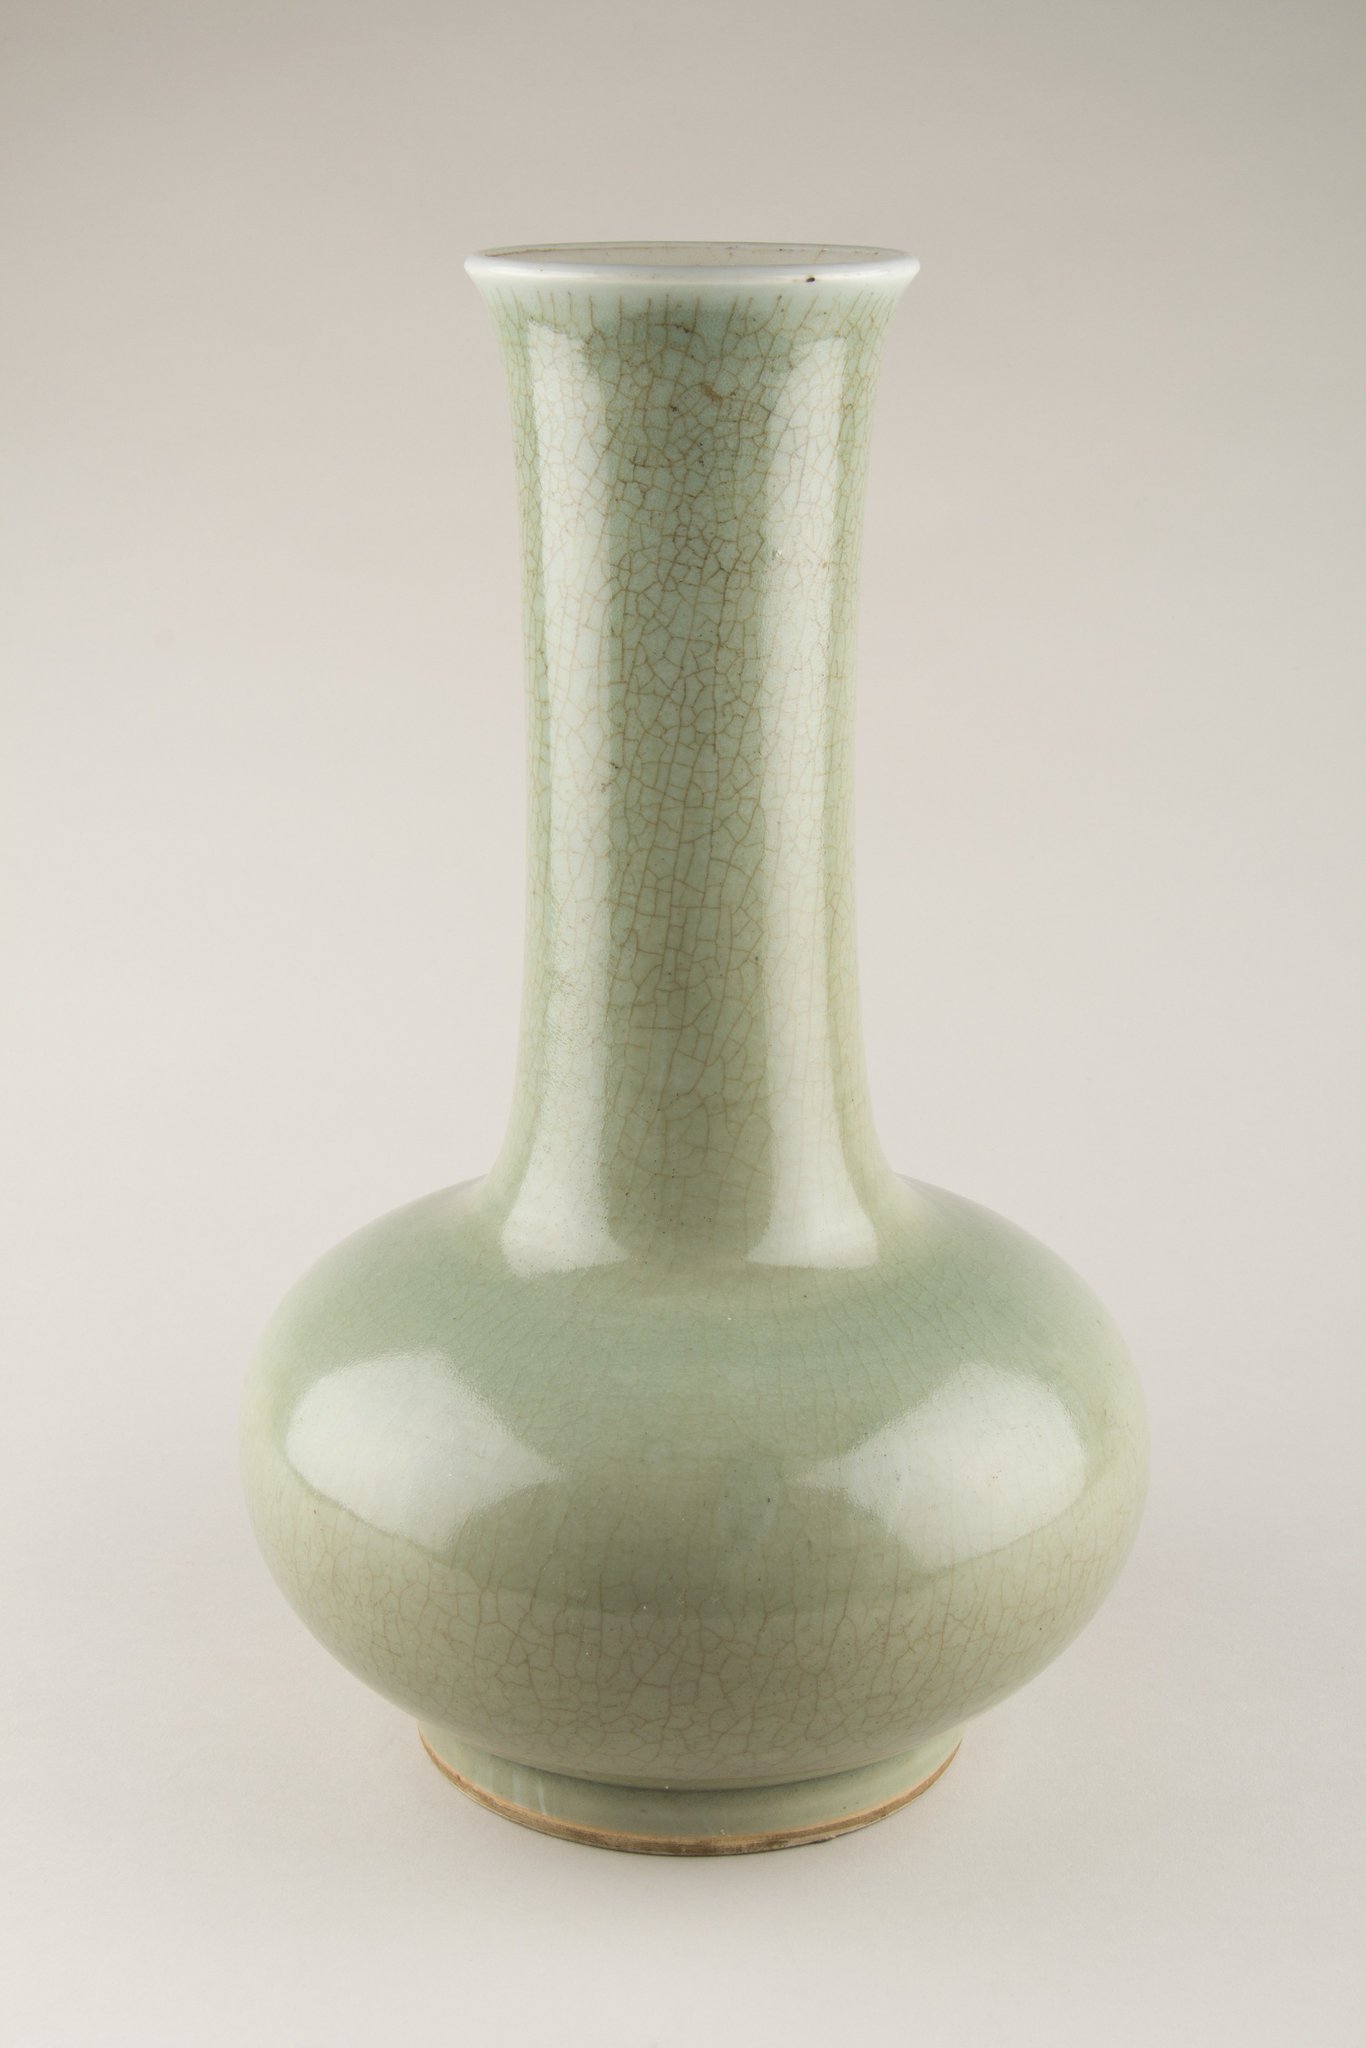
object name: bottle vase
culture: chinese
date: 1667-1733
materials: glaze, porcelain